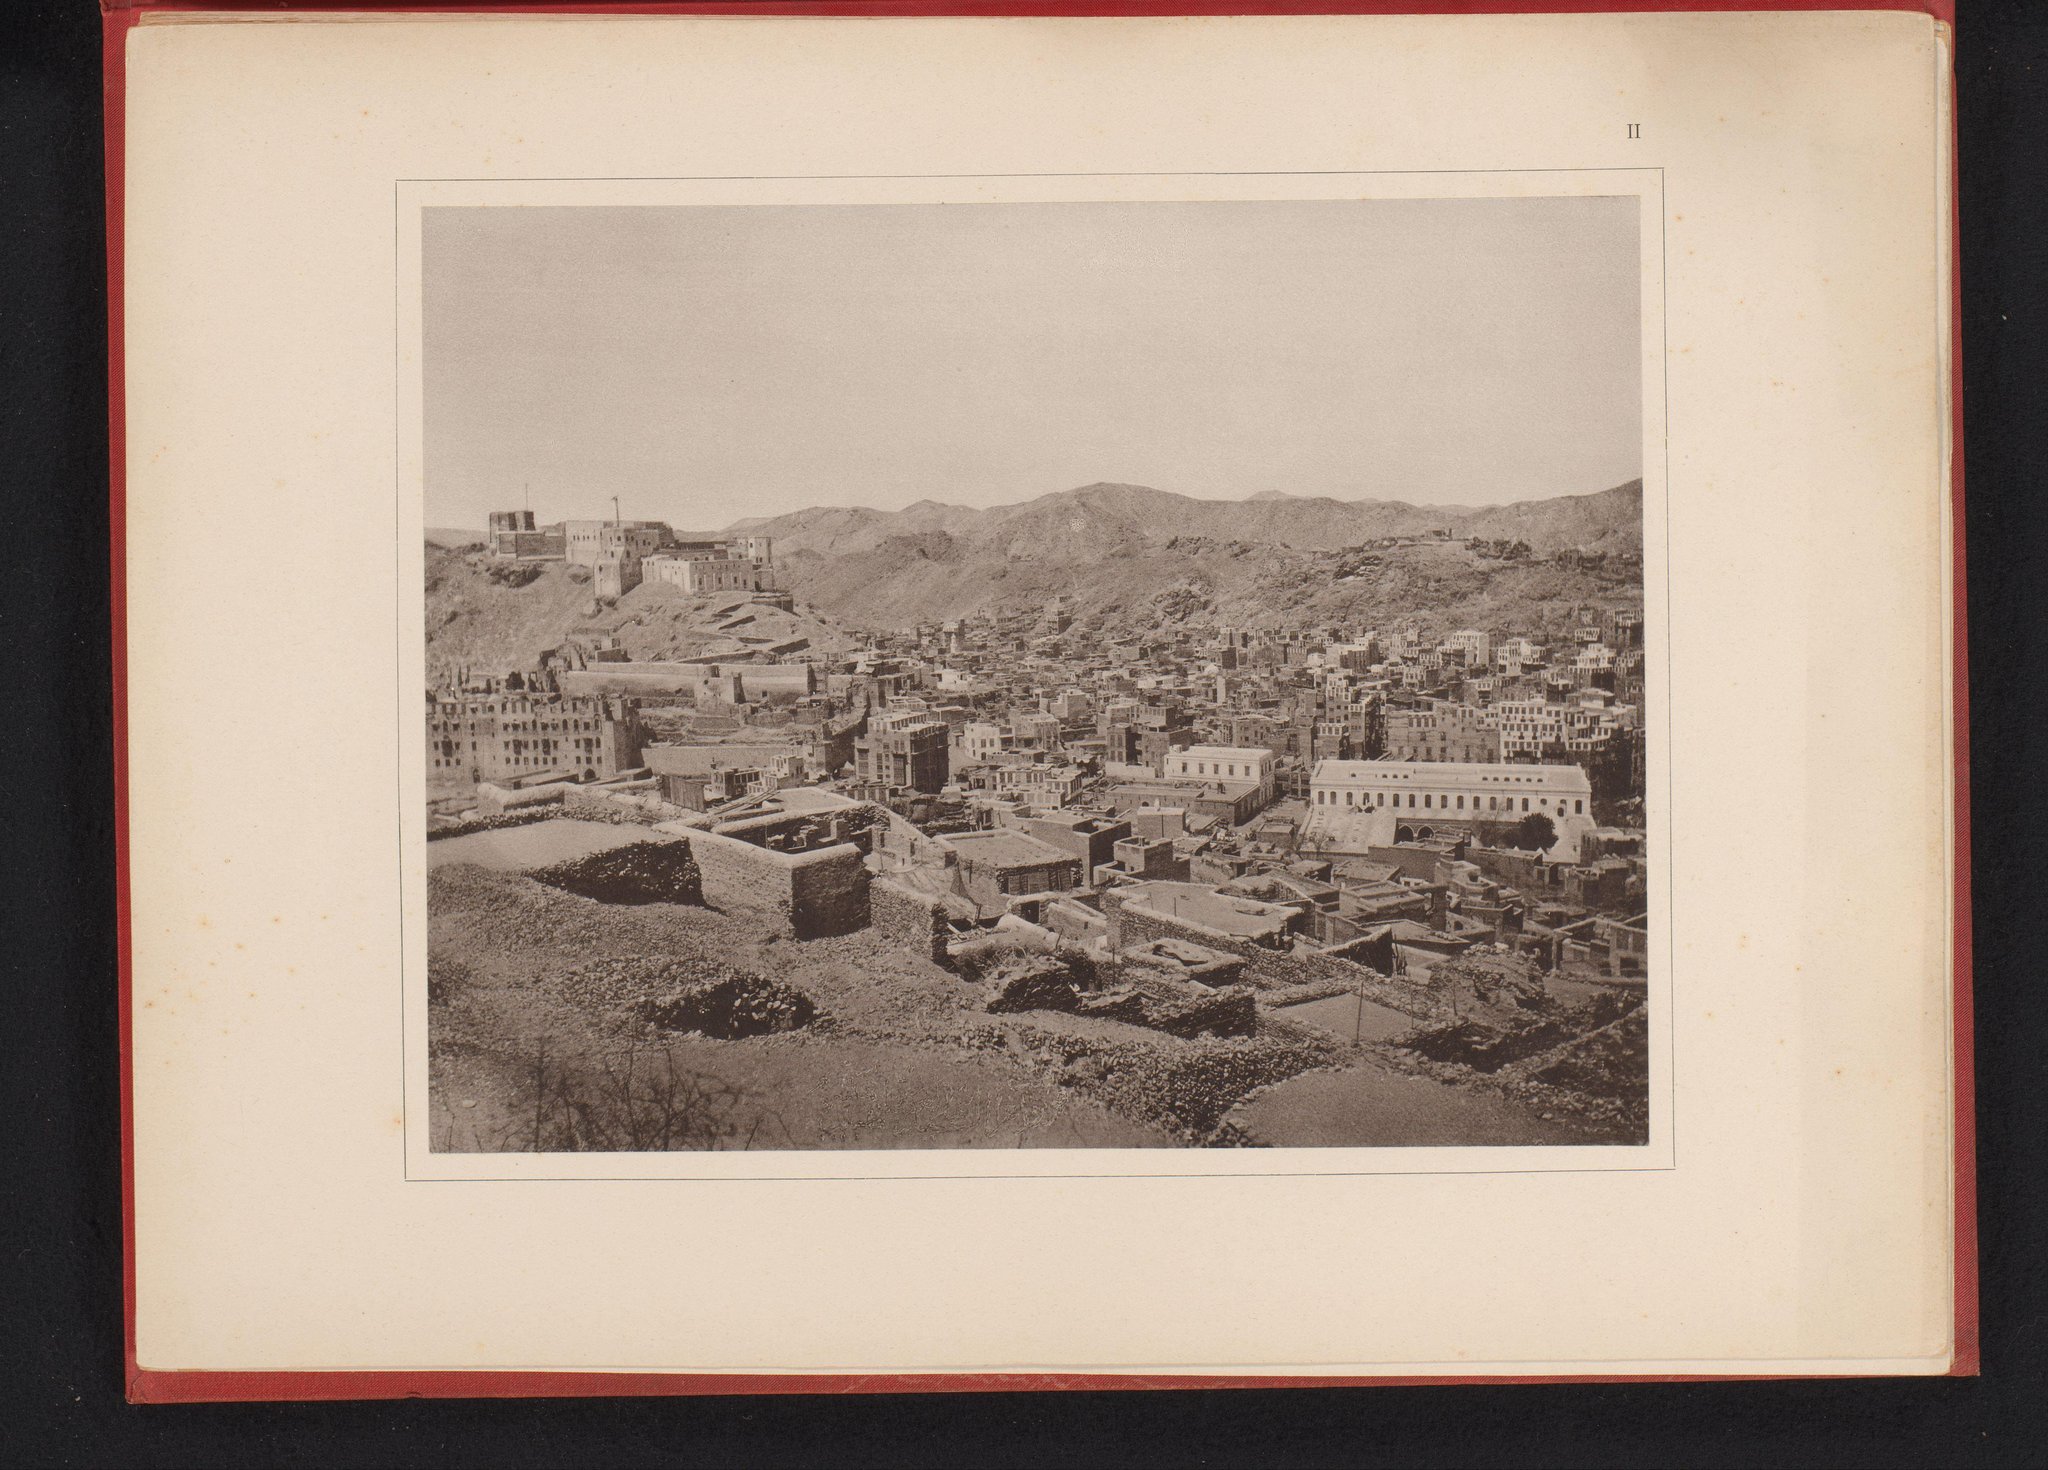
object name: photomechanical print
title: Gezicht op Mekka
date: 1889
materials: cardboard, paper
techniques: photograph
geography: mecca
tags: city-view in general; 'veduta'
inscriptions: number: ‘II’